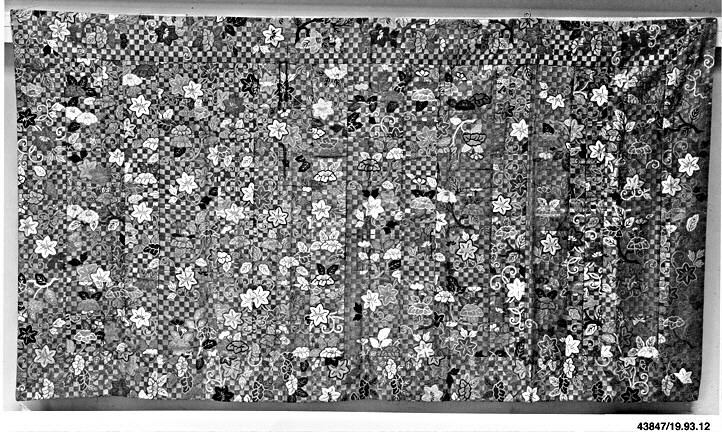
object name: robe, priest's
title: Priest's Robe (Shichijō)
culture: japanese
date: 1648-1652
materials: silk